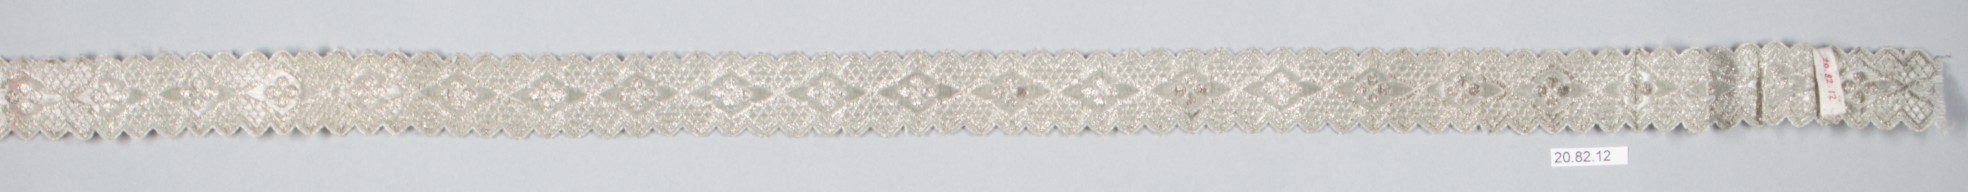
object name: ribbon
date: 1801-1833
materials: metal thread, silk